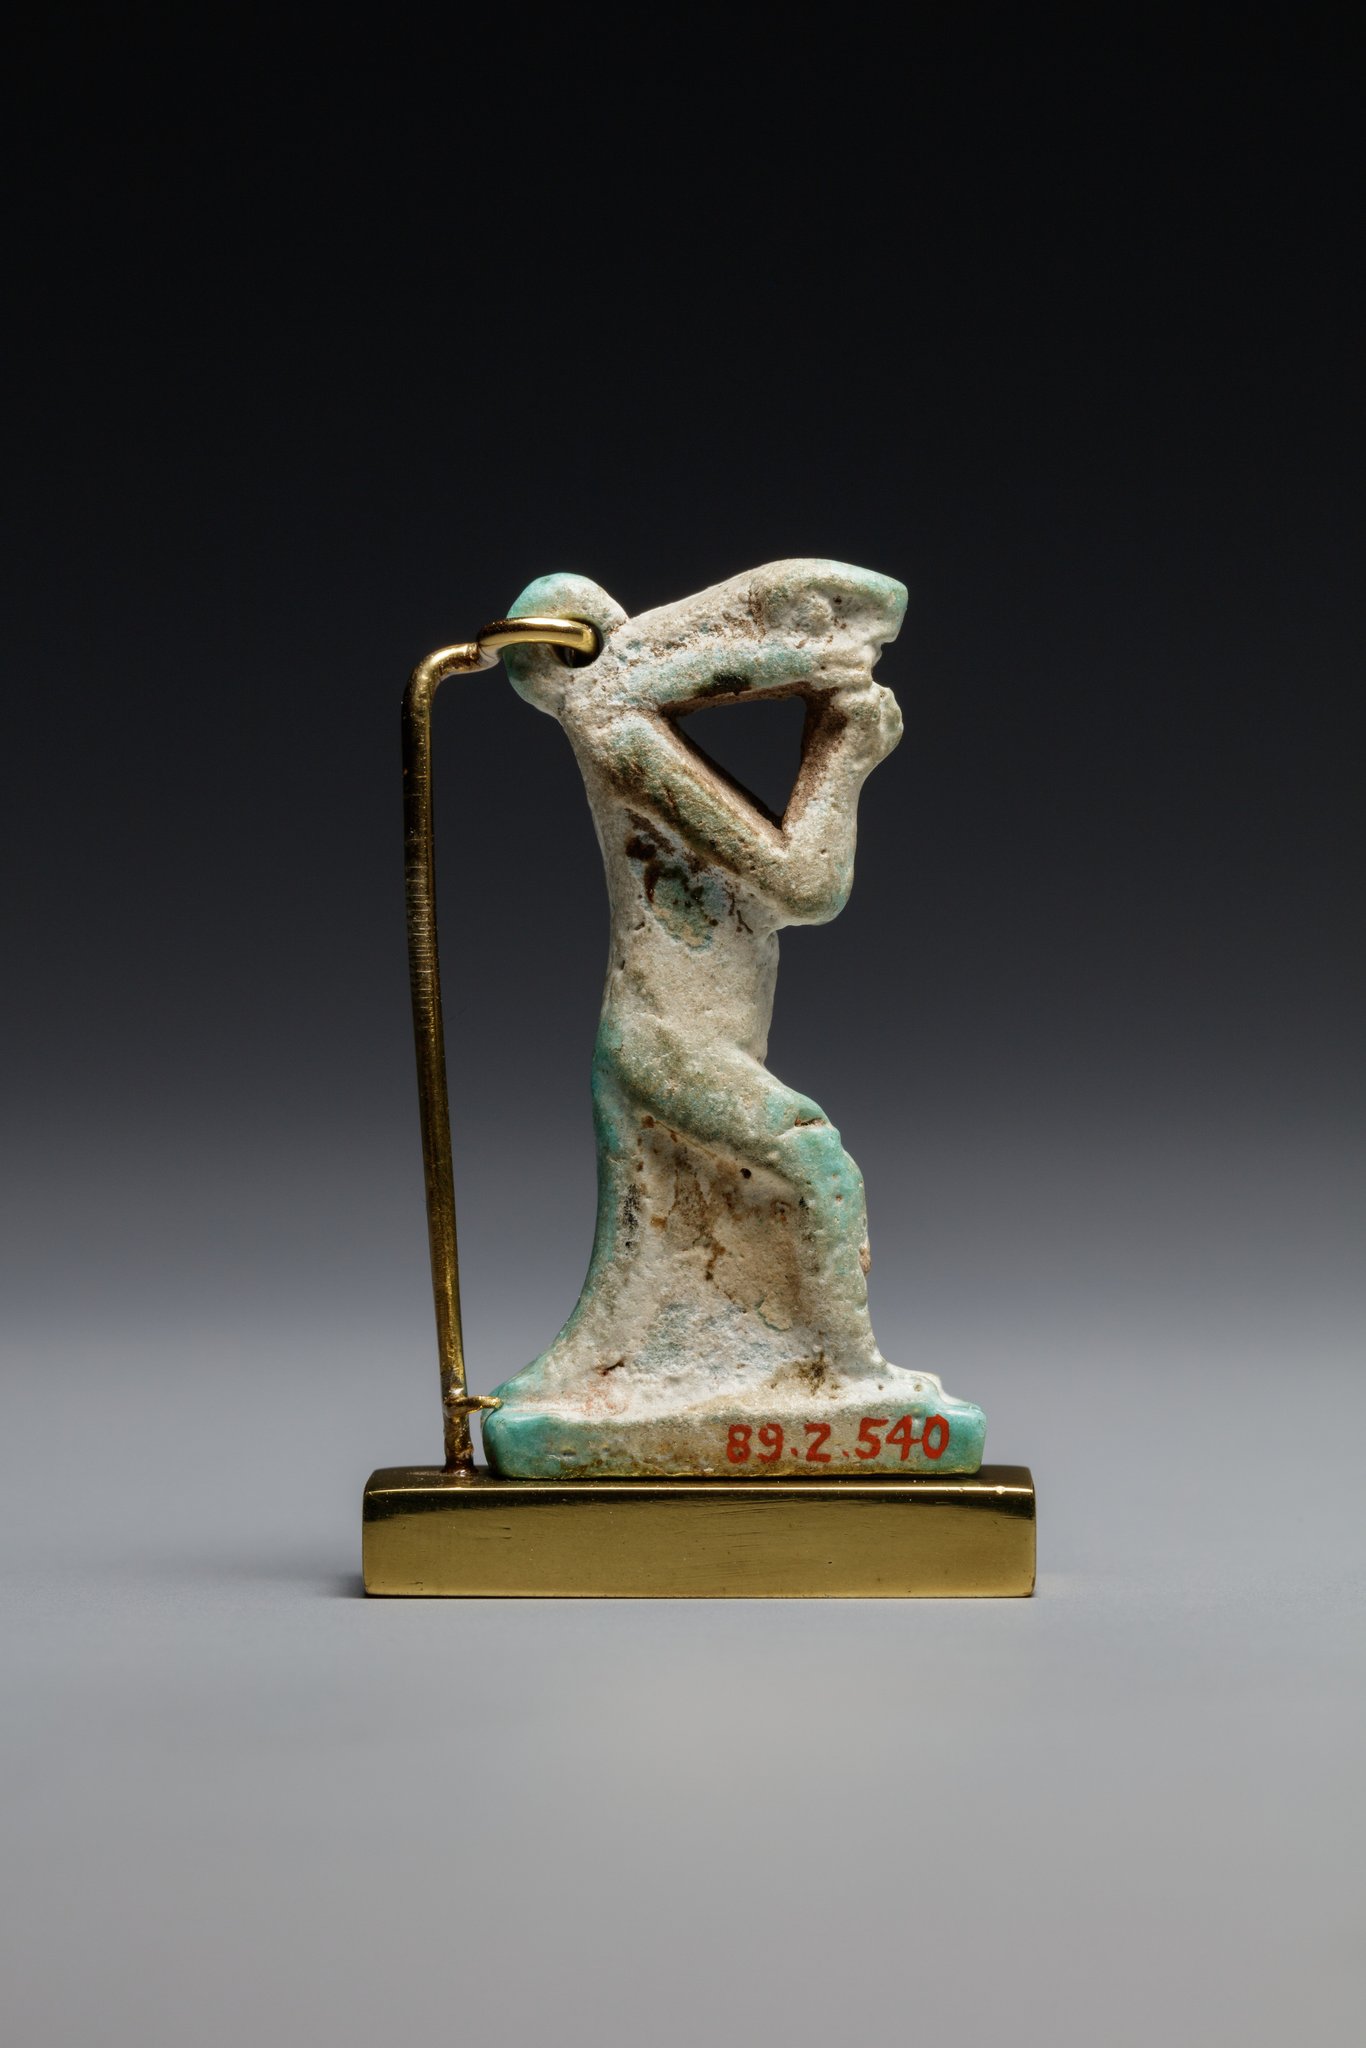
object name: amulet, nehebkau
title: Nehebkau (snake deity)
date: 664-332 BCE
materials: faience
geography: egypt